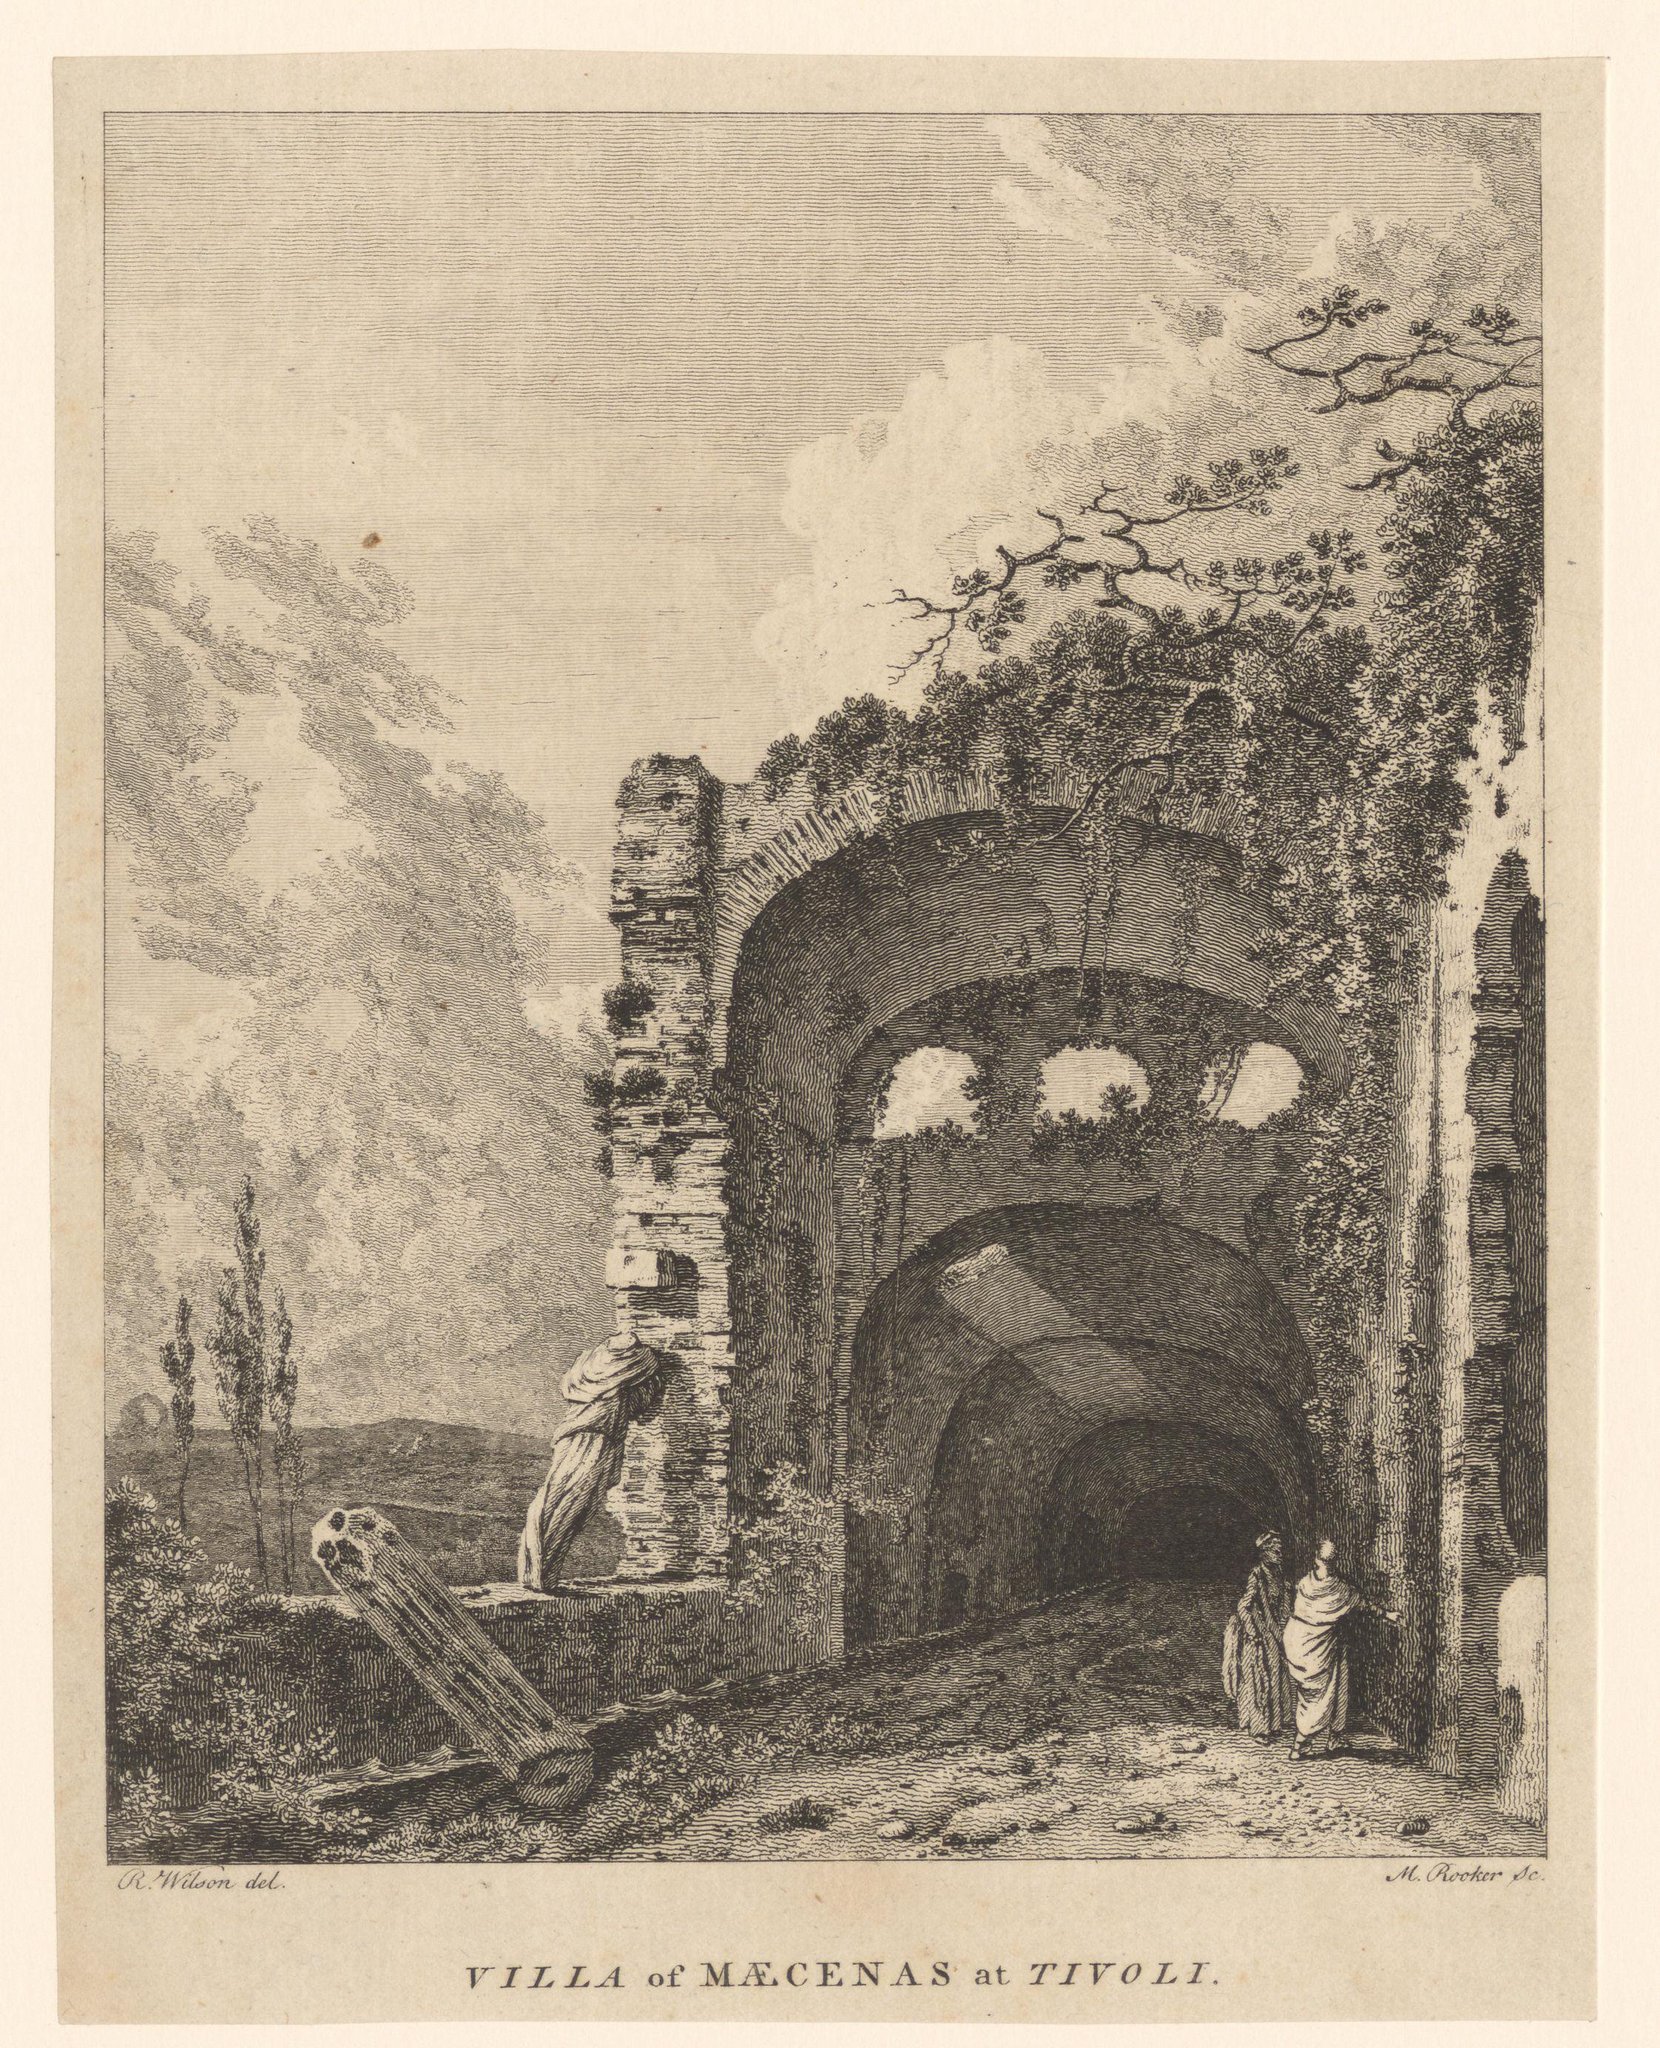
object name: print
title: Villa of Maecenas at Tivoli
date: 1765-1801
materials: paper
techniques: etching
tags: villa, landscape with ruins (+ city(-scape) with figures, staffage), temple of hercules victor, tivoli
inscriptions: collector's mark: Lugt 2228